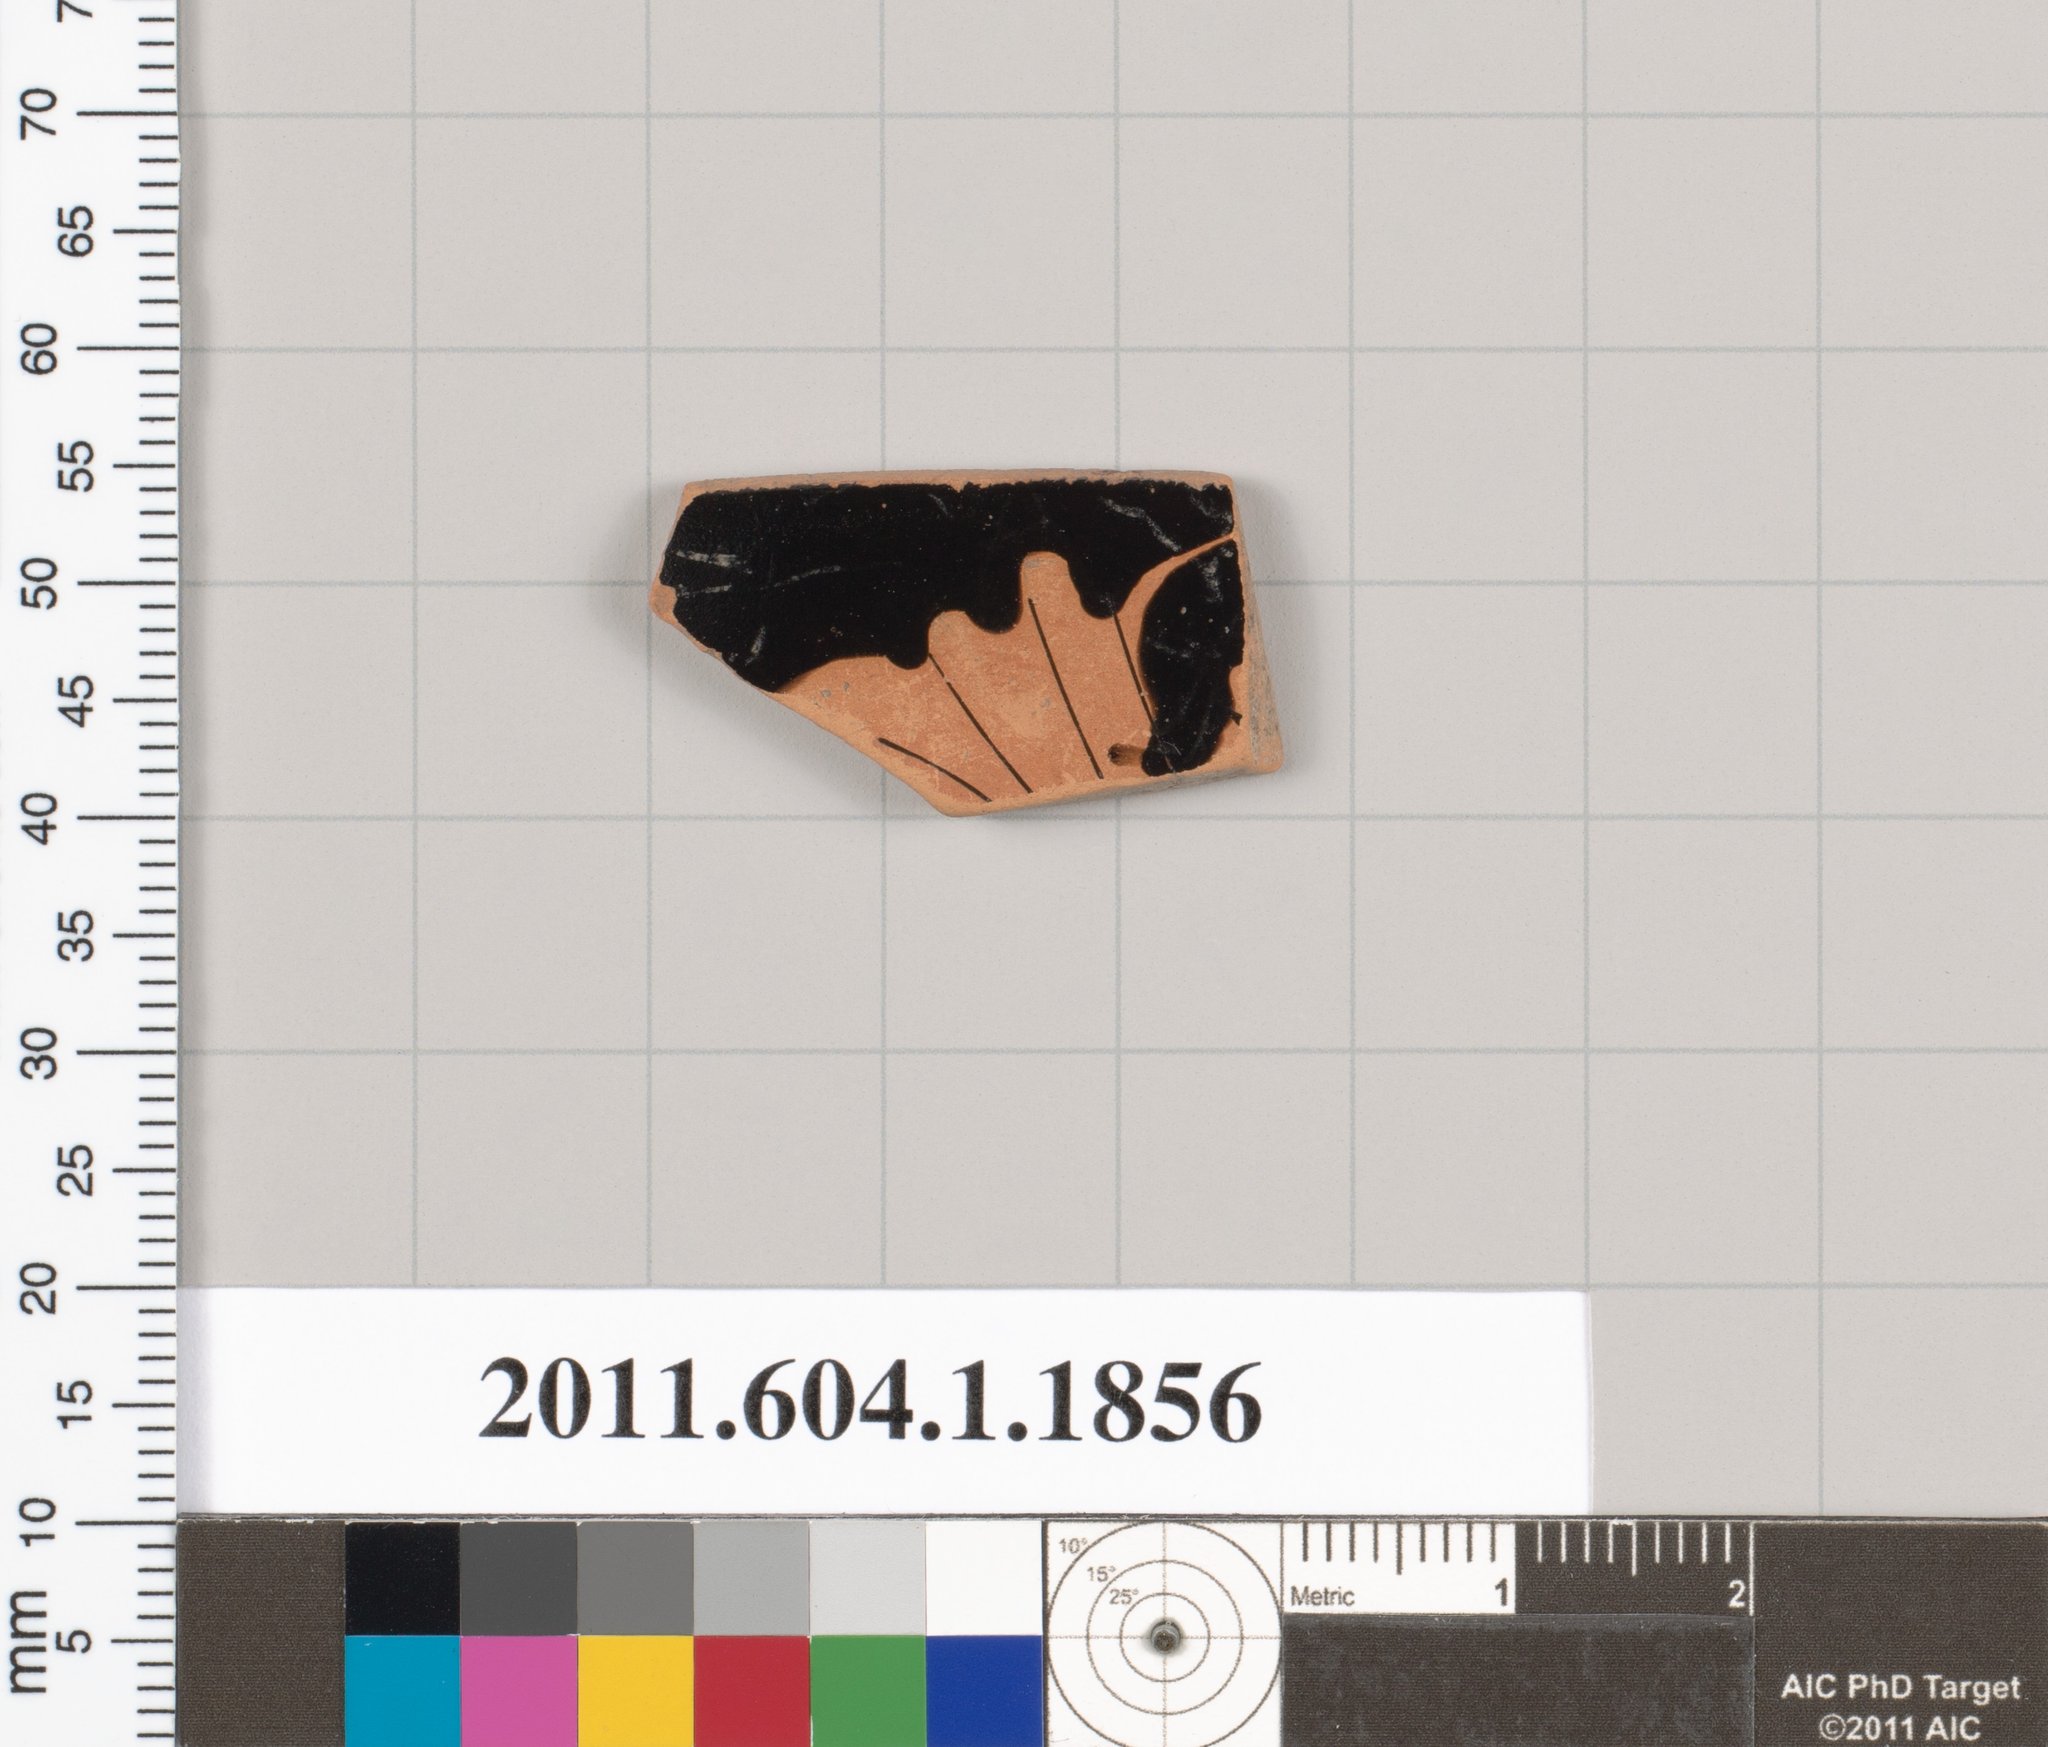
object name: kylix fragment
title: Terracotta rim fragment of a kylix (drinking cup)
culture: greek, attic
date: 475-451 BCE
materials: terracotta